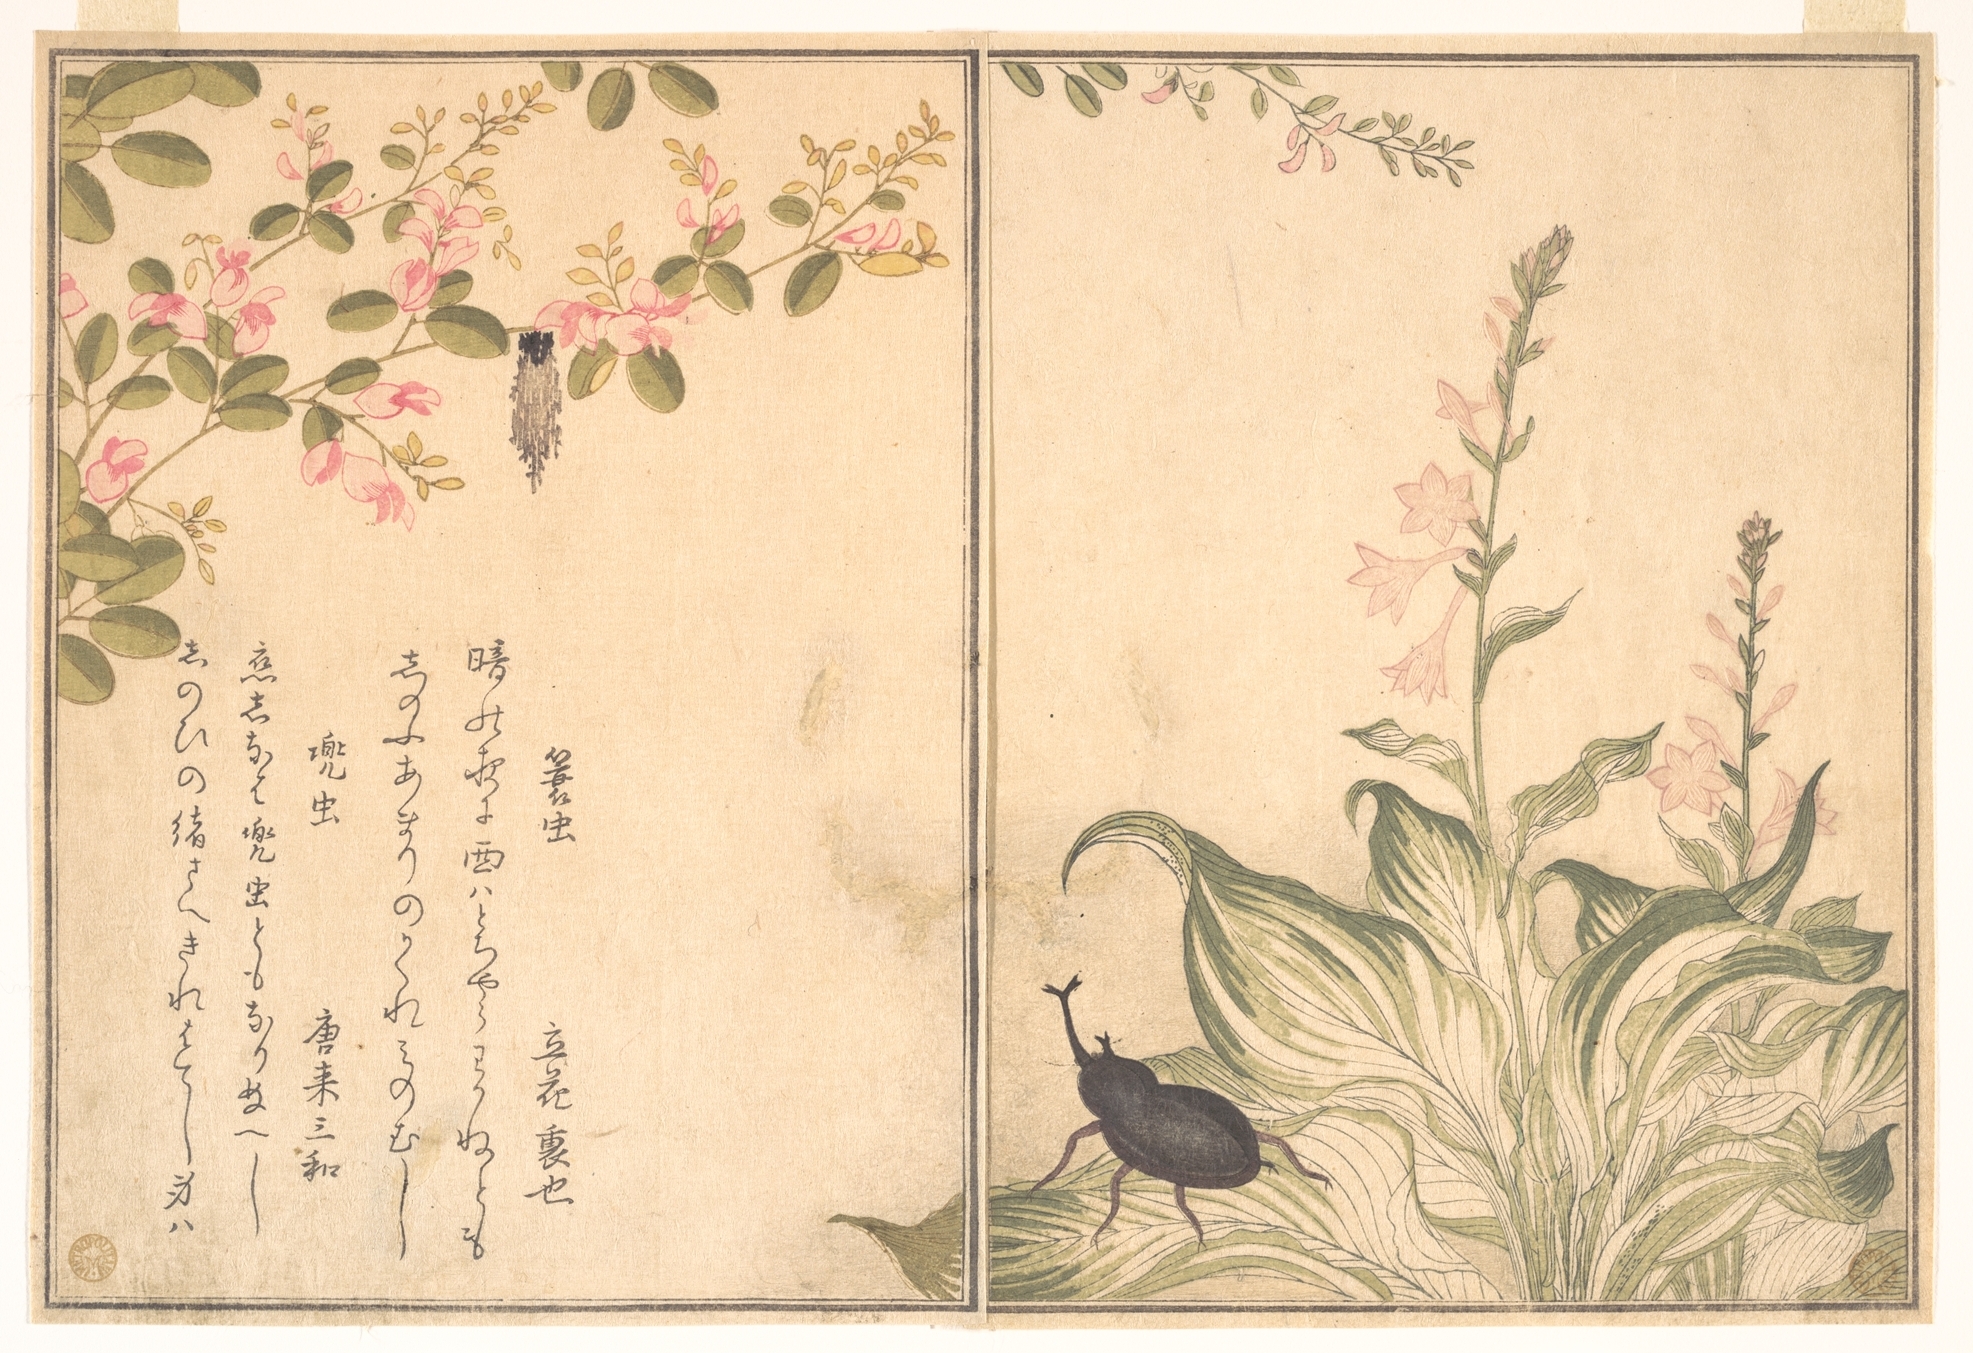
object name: woodblock print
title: Bagworm (Minomushi); Horned Scarab Beetle (Kabutomushi), from the Picture Book of Crawling Creatures (Ehon mushi erami)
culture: japanese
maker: kitagawa utamaro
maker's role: artist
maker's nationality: japanese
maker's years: 1754-1806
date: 1788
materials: ink, paper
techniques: woodblock print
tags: insects,plants